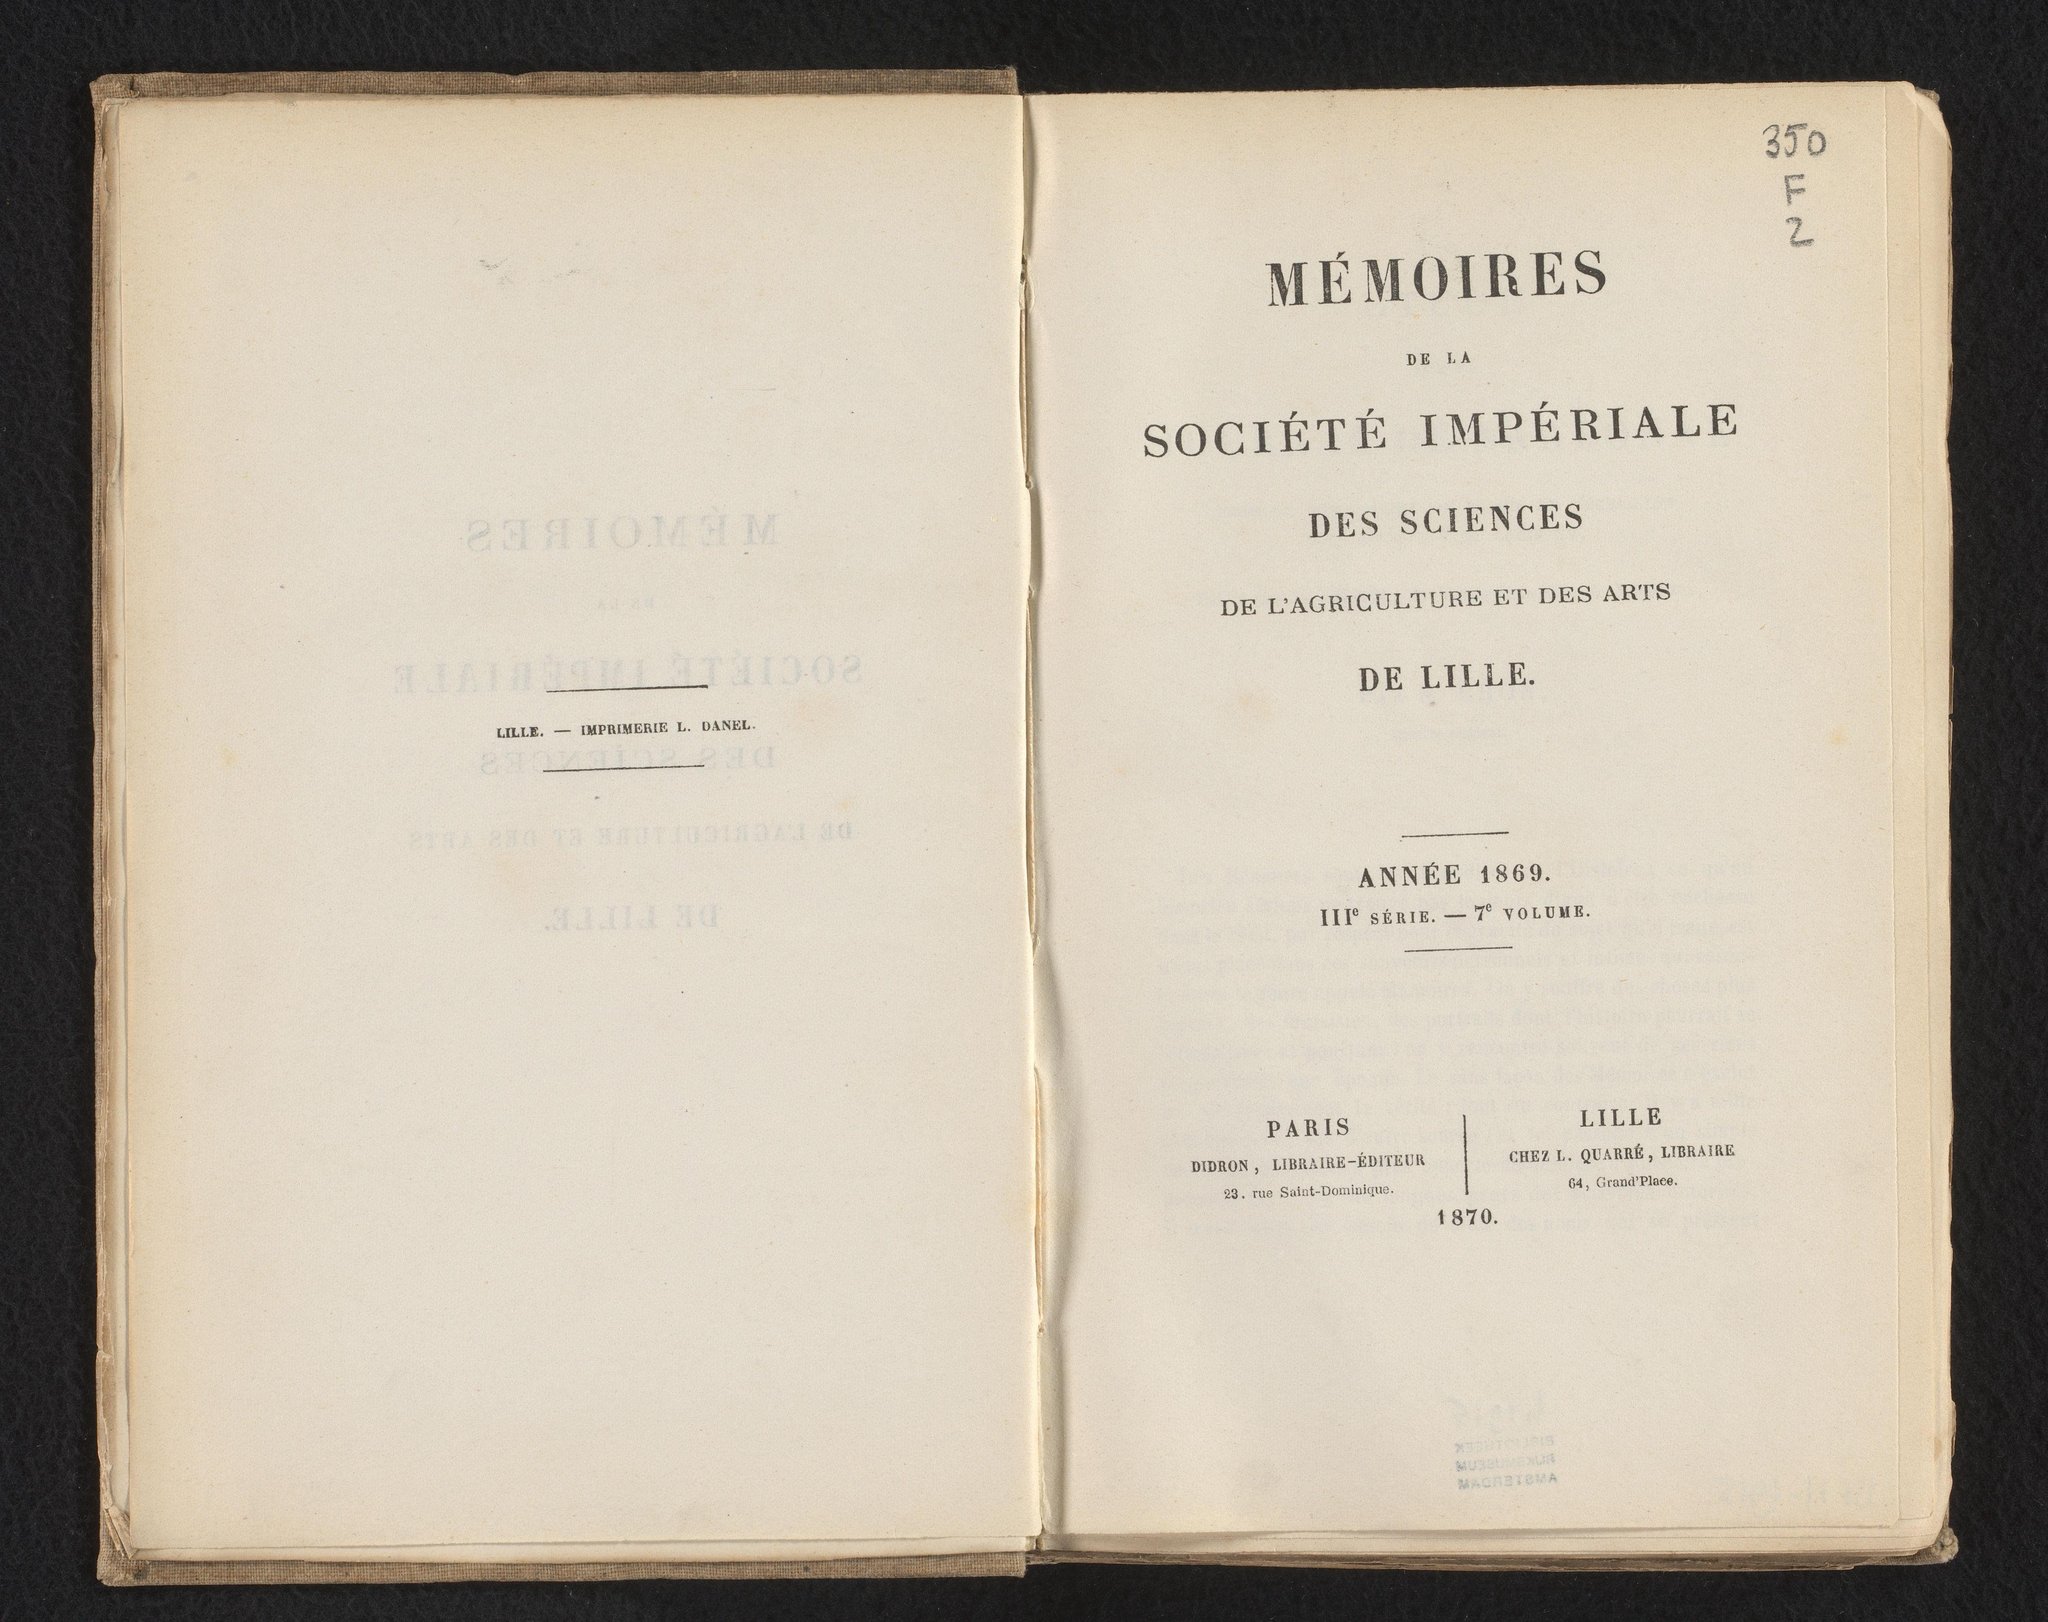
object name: book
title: Mémoires de la Société Impériale des Sciences de l'Agriculture et des Arts de Lille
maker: victor didron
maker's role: publisher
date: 1870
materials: cardboard, paper, linen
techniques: carbon print, letterpress printing, lithograph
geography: lille